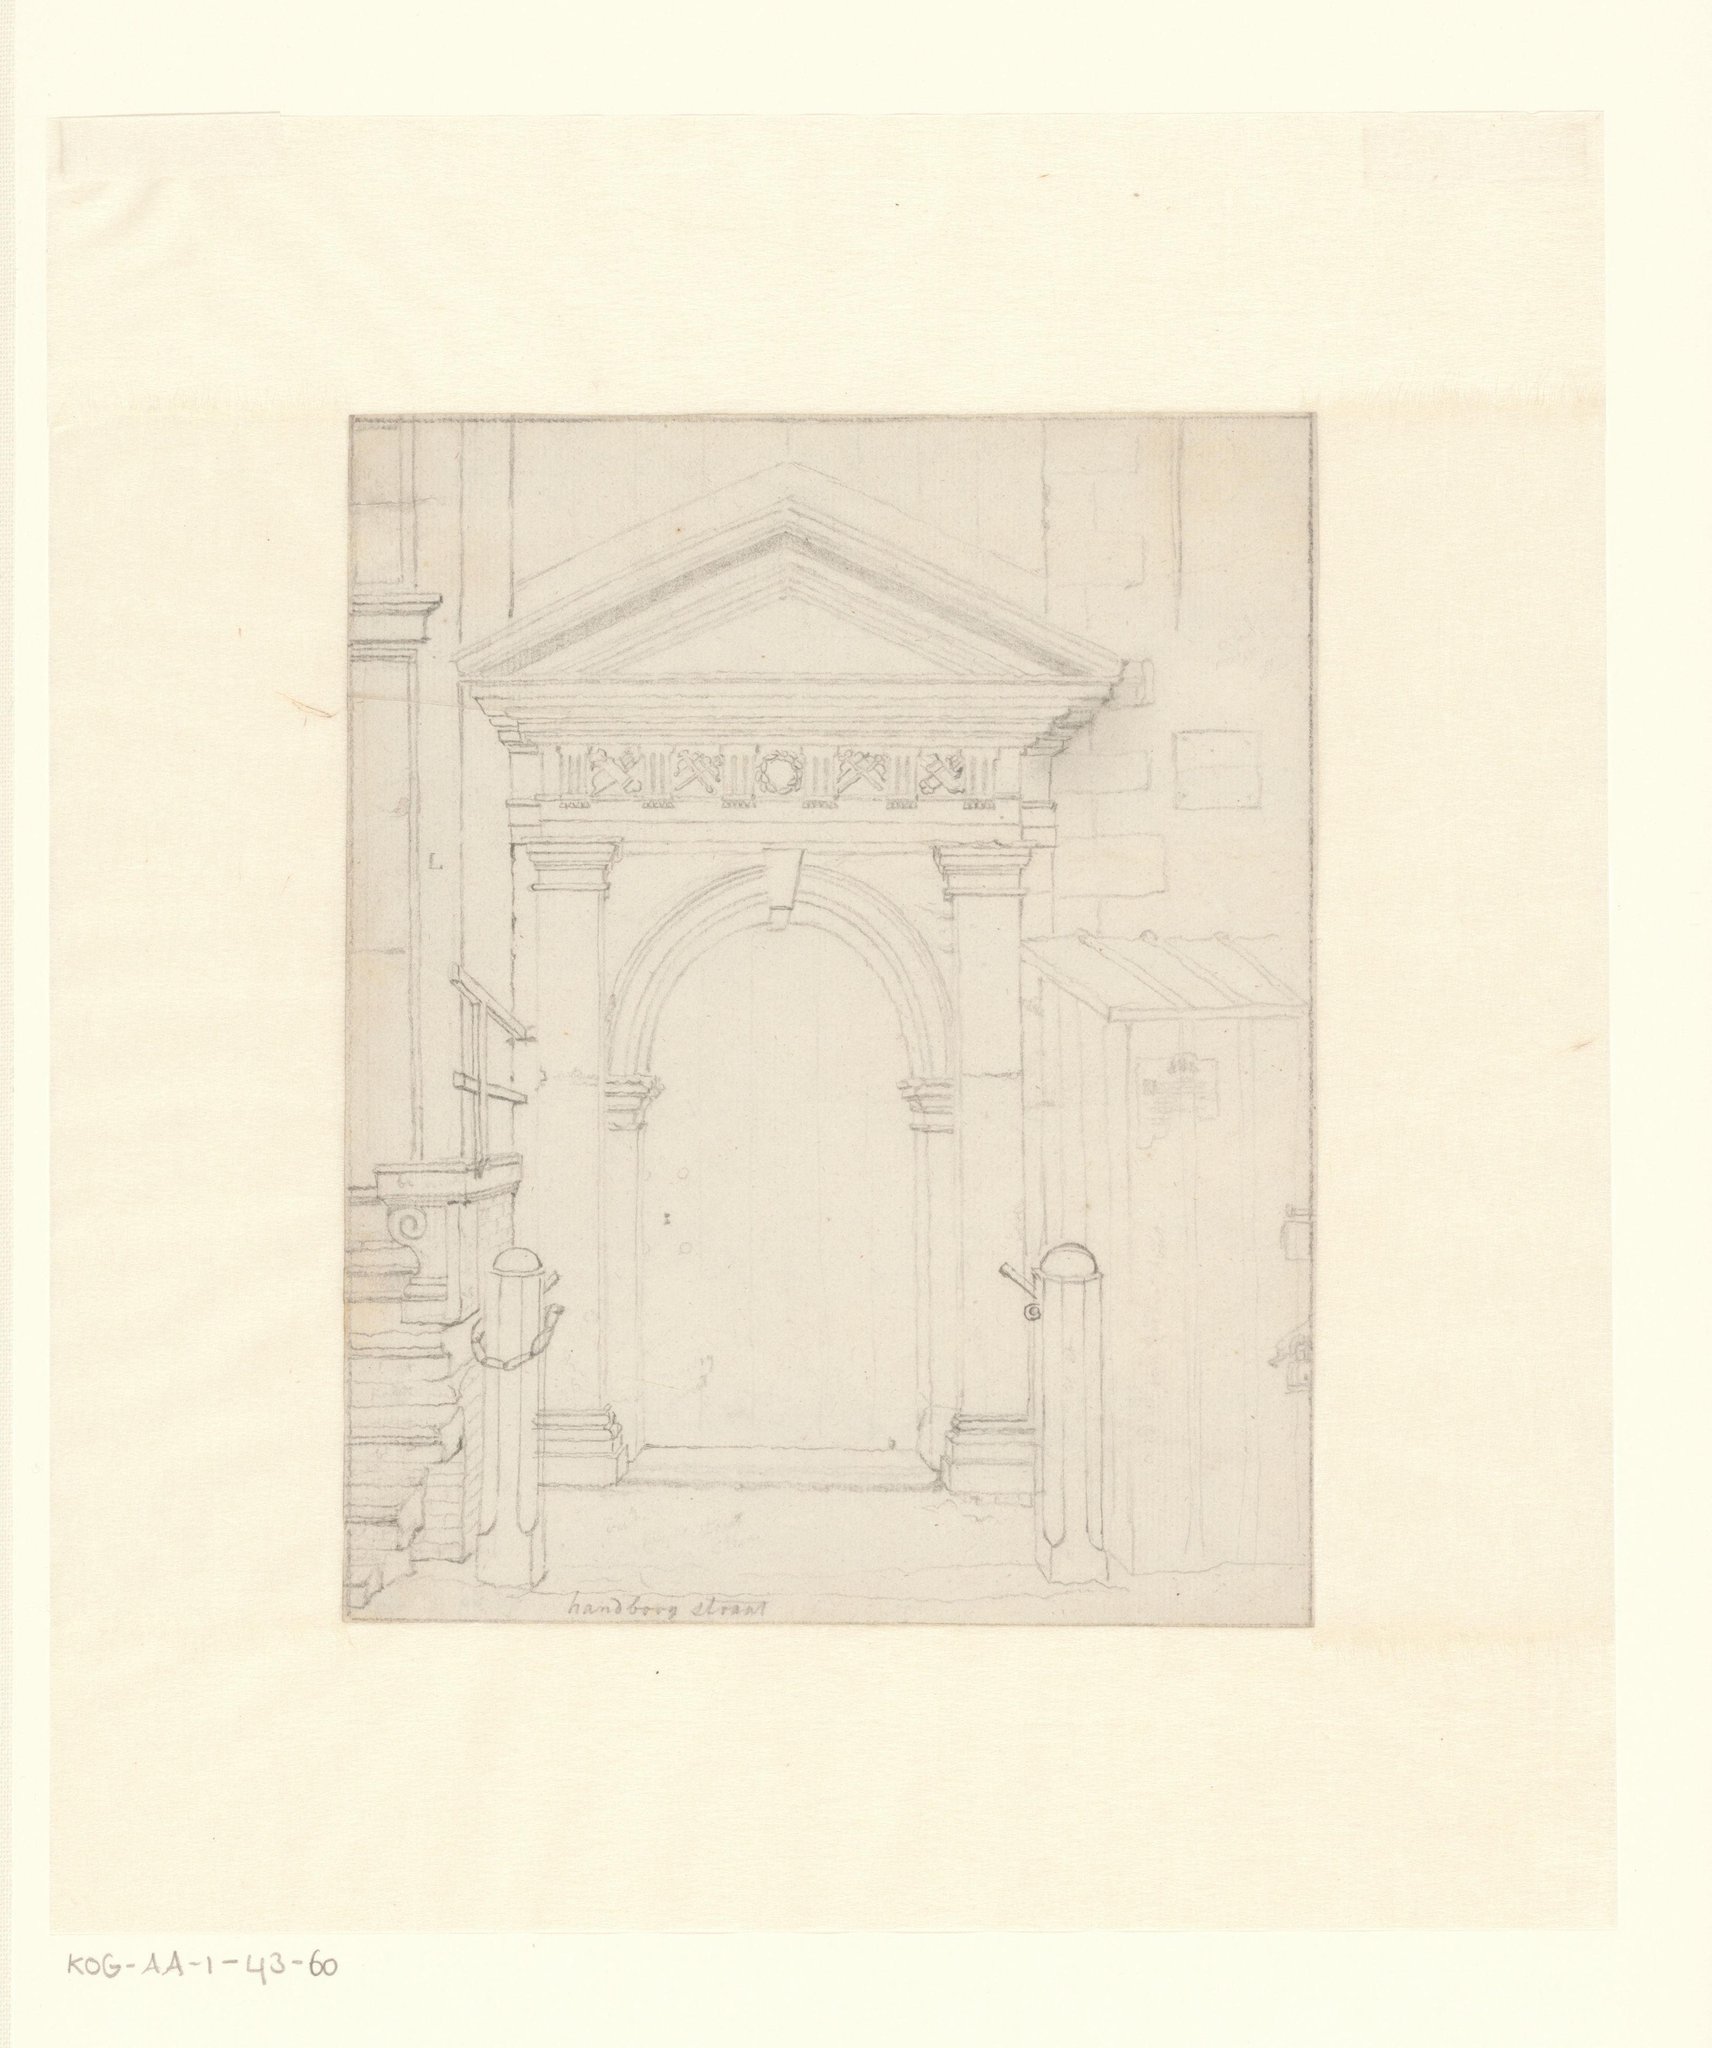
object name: drawing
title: Gezicht op de poort van het West-Indisch Huis aan de Handboogstraat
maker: hermanus petrus schouten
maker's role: draughtsman, painter, print maker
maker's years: 1747-1822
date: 1757-1822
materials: paper, pencil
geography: amsterdam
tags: city-view in general; 'veduta', gate, entrance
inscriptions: inscription: ‘op oud opzetvel: Poort West Indische Huis / Handboogstraat / door H.P. Schouten’, inscription: ‘handboog straat’, inscription: ‘poorten van 't west indise huijs / in de hand boog straat’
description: Onderwerpsrubriek binnen de Atlas Amsterdam: WIC.